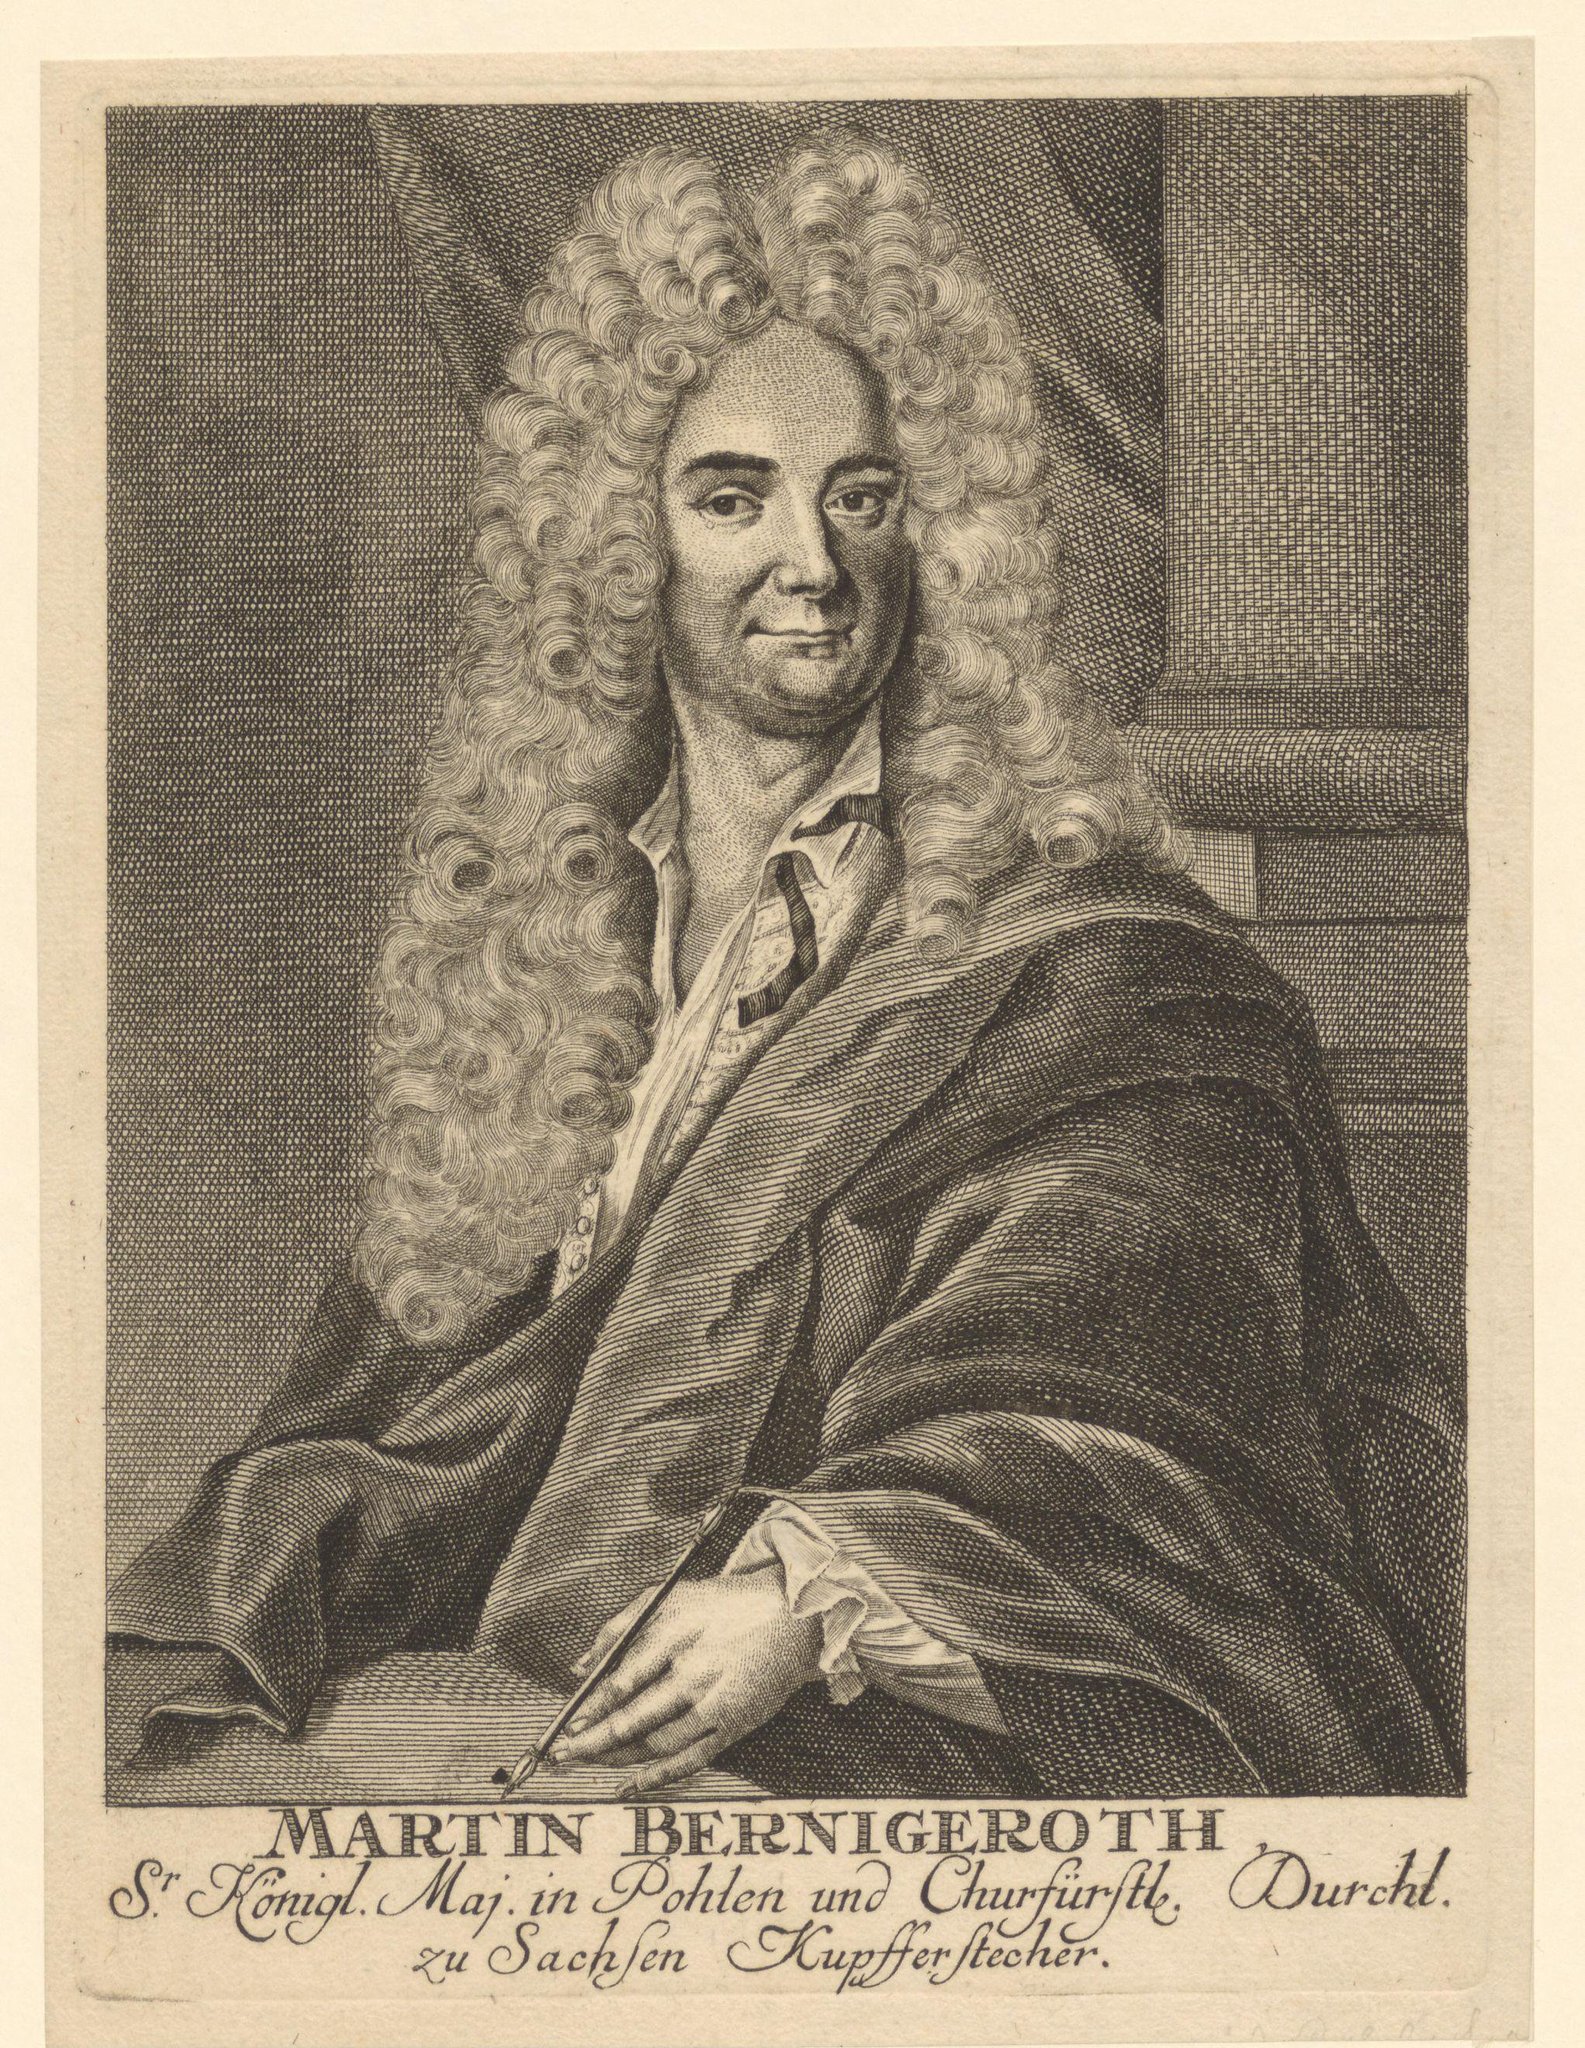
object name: print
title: Portret van Martin Bernigeroth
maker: Anonymous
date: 1725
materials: paper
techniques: engraving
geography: germany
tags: martin bernigeroth, historical persons, tools, implements of graphic artist, portrait, self-portrait of artist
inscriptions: collector's mark: Lugt 2228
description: Prent ook gebruikt in: Blank, Johann Leonhard. Bildnisse berühmter Künstler Buchhändler Buchdrucker und anderer Männer welche sich so wohl in als auserhalb Teutschland verdient gemacht. Neurenberg: Johann Leonhard Blank, 1725.